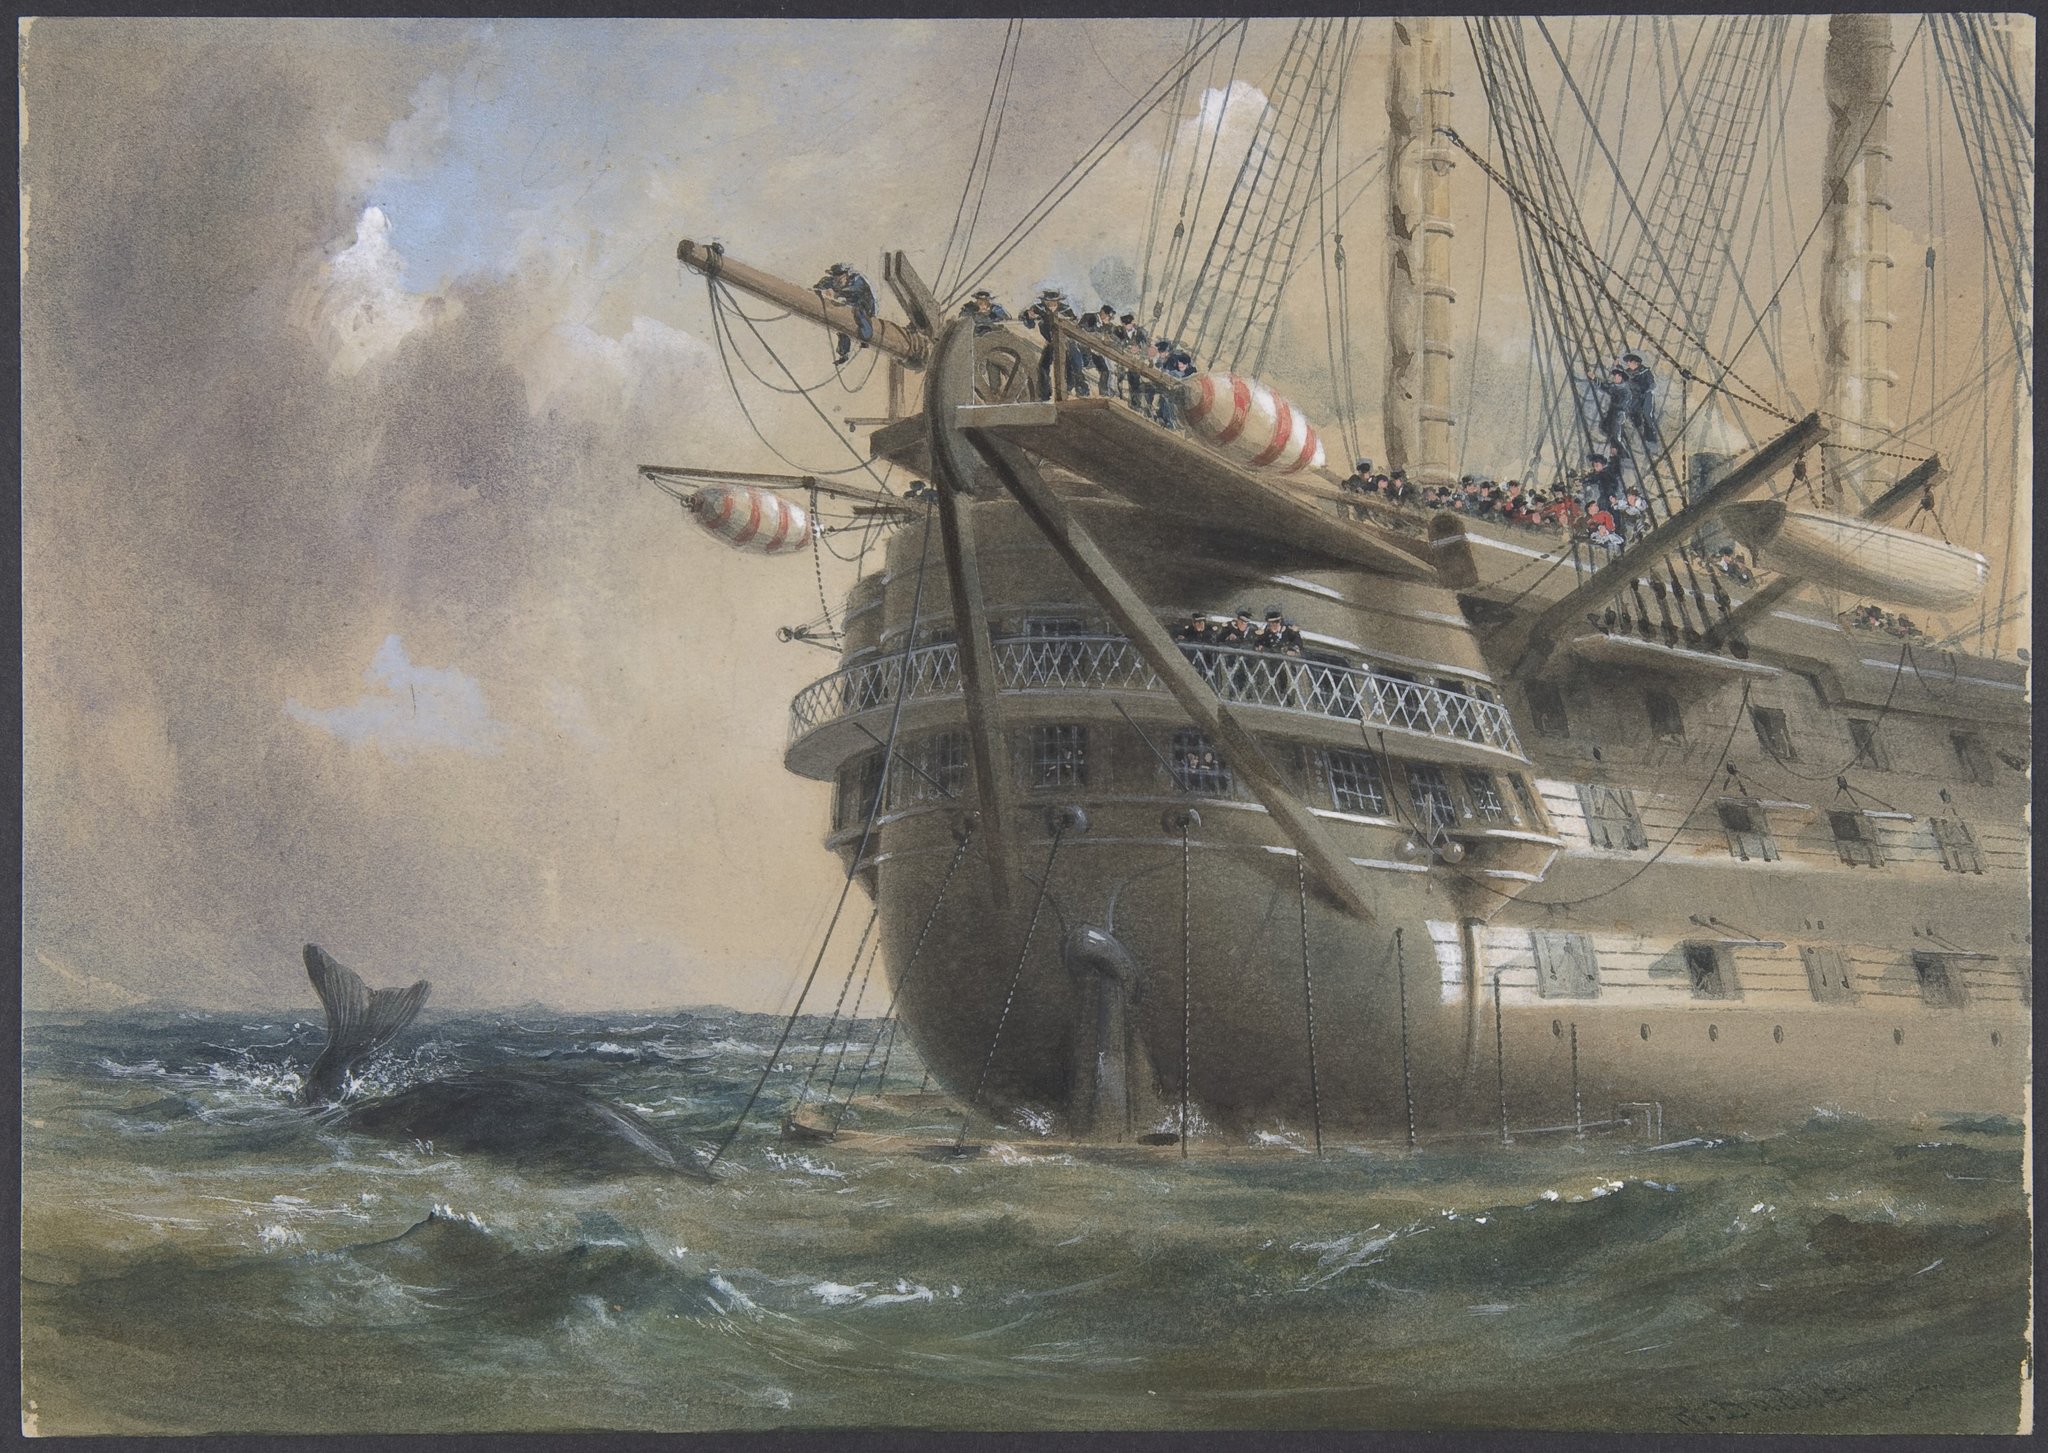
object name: drawing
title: H.M.S. Agamemnon Laying the Atlantic Telegraph Cable in 1858: a Whale Crosses the Line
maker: robert charles dudley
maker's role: artist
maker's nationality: british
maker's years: 1826-1909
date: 1865-1866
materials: gouache, graphite, watercolor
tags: whales,industry,ships,transatlantic cable